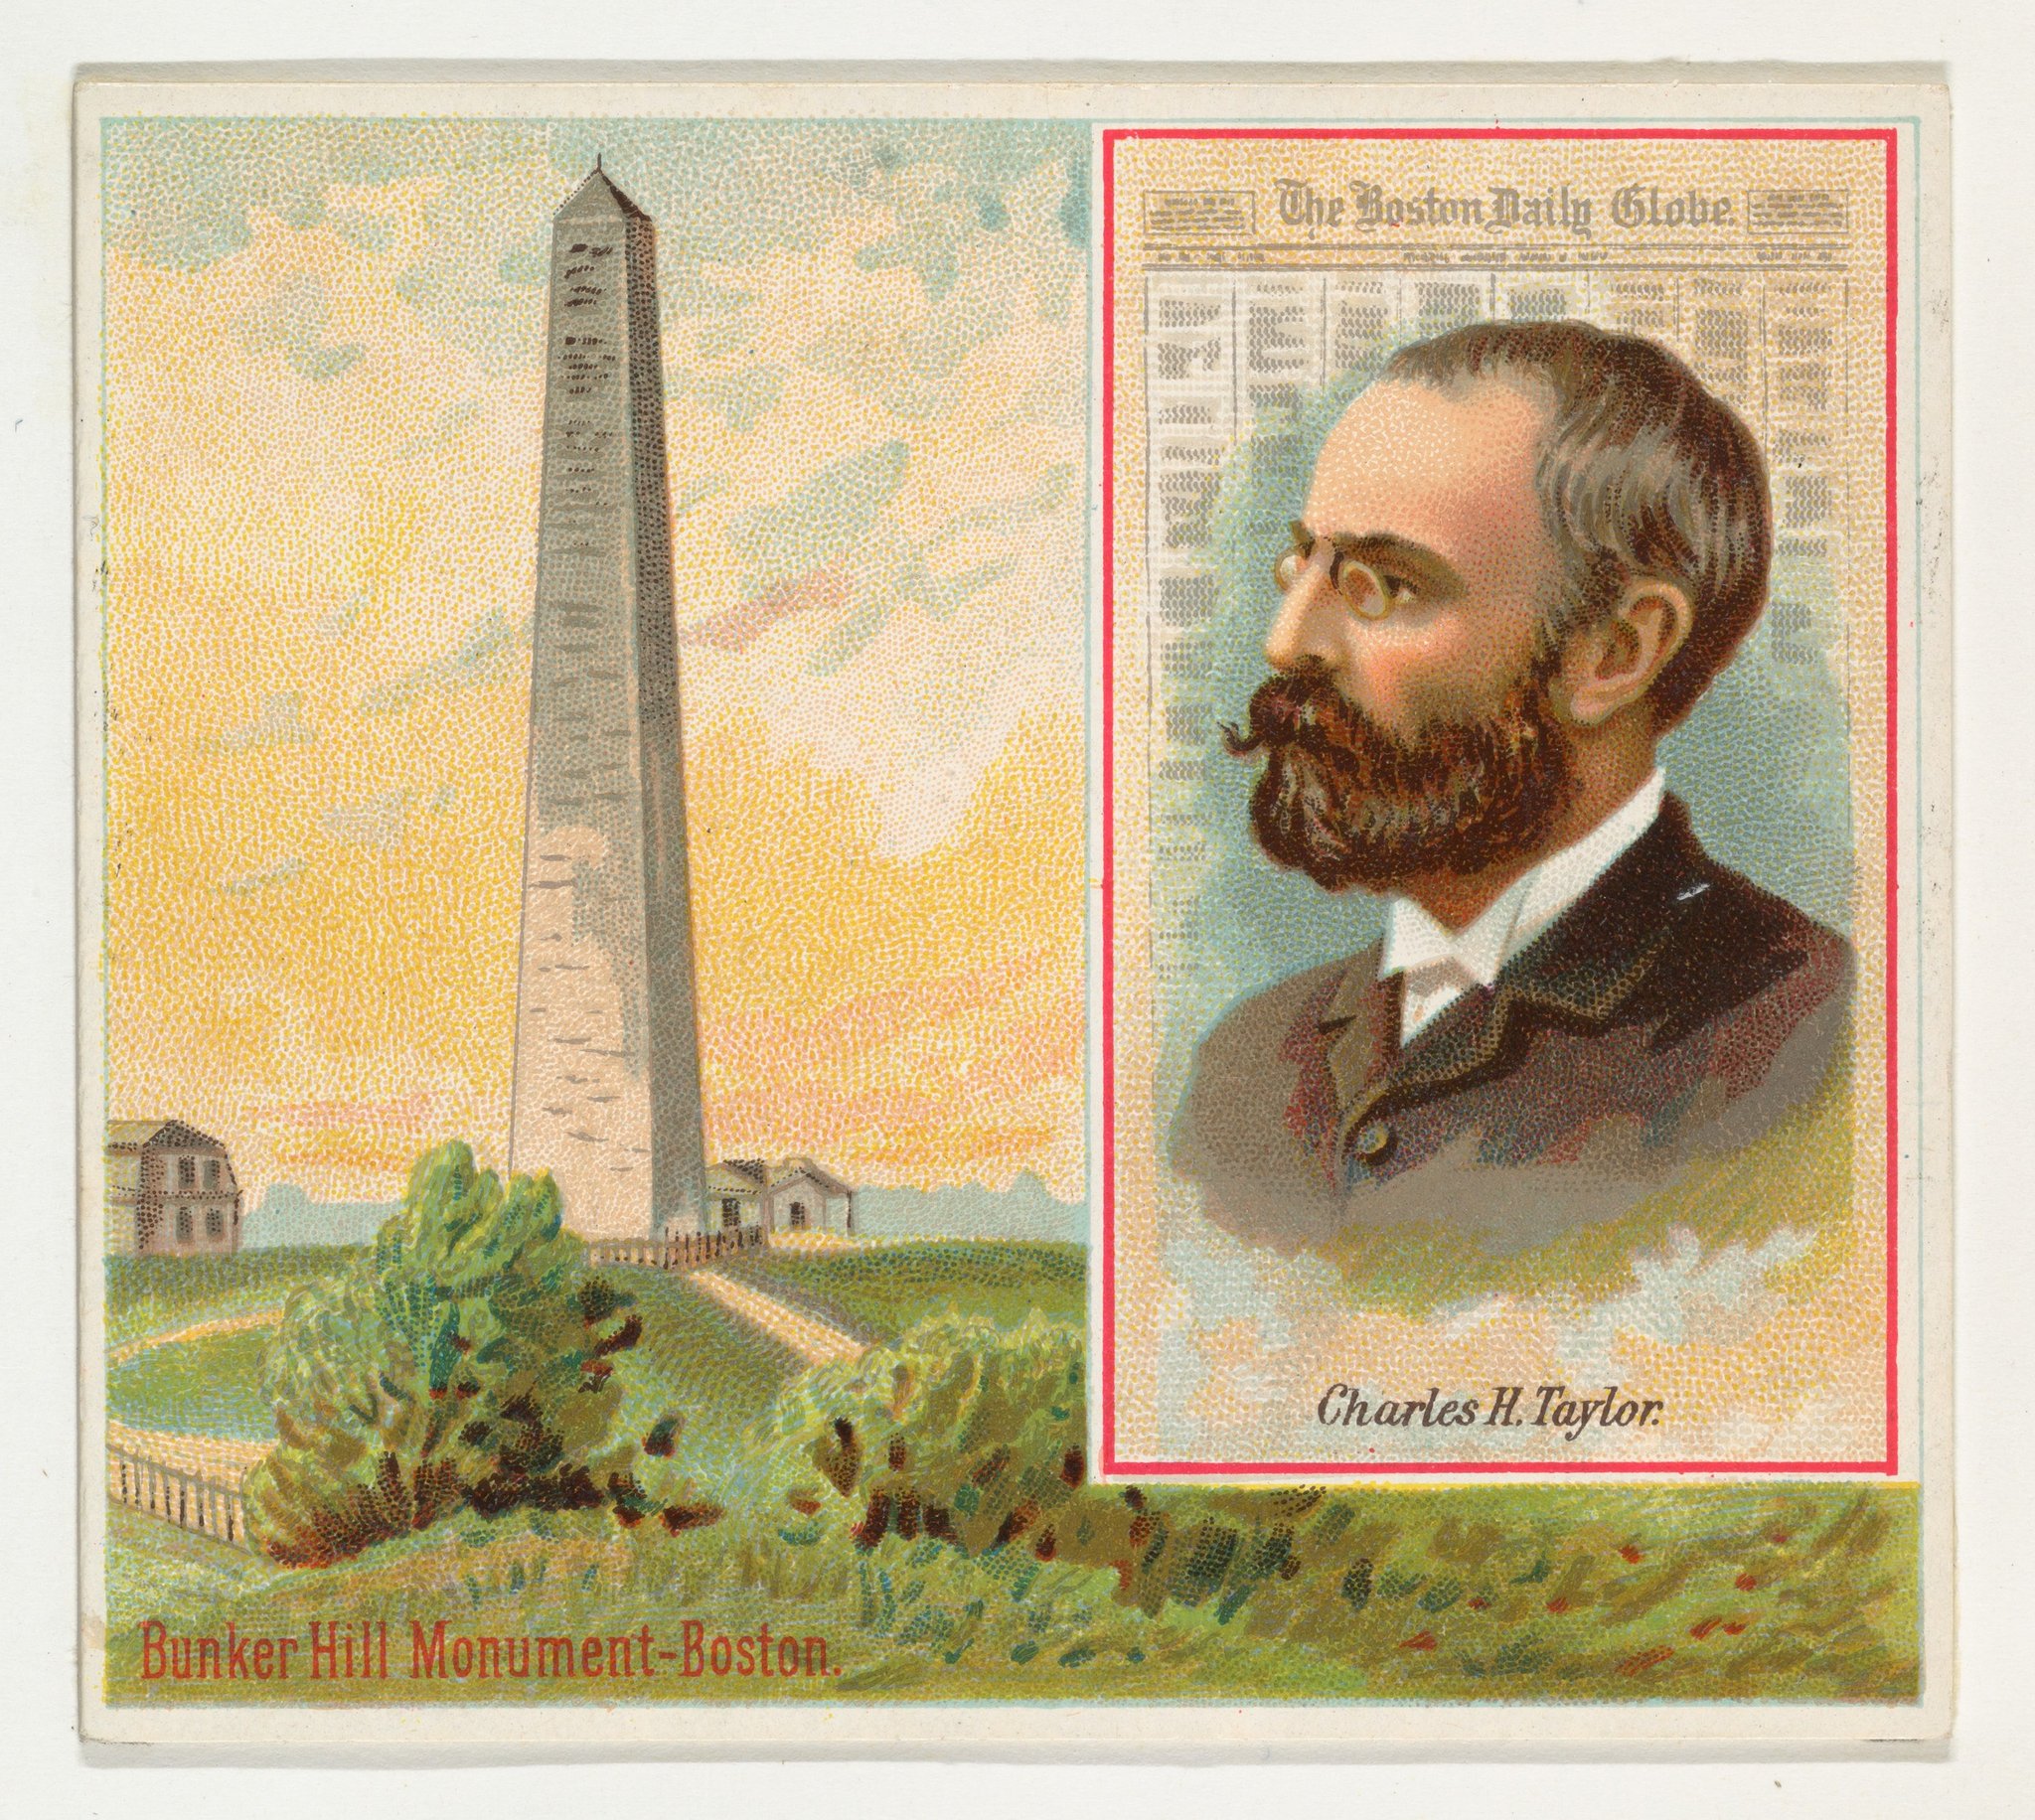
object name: print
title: Charles H. Taylor, The Boston Daily Globe, from the American Editors series (N35) for Allen & Ginter Cigarettes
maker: allen & ginter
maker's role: publisher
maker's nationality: american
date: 1887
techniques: color lithograph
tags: obelisks,men,profiles